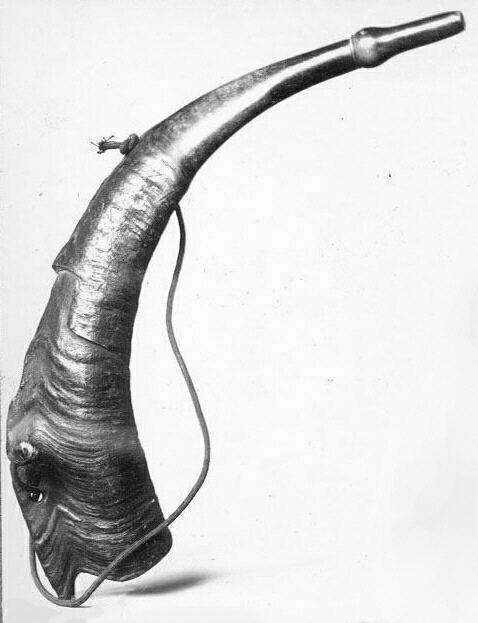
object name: reed horn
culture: african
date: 1867-1900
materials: horn, metal